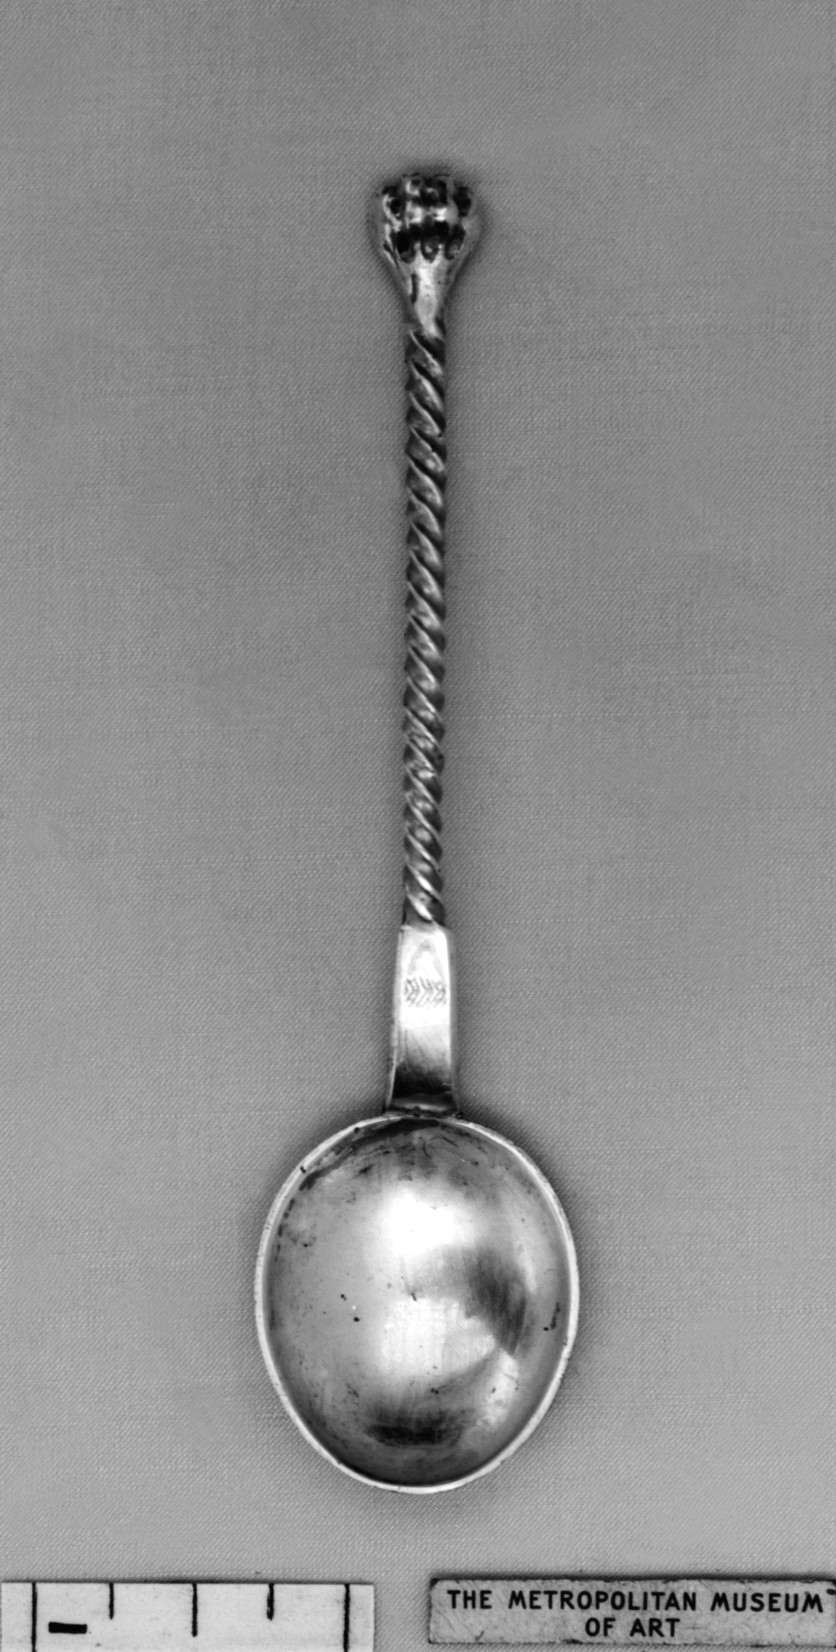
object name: salt spoon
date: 1801-1900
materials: gilt, silver